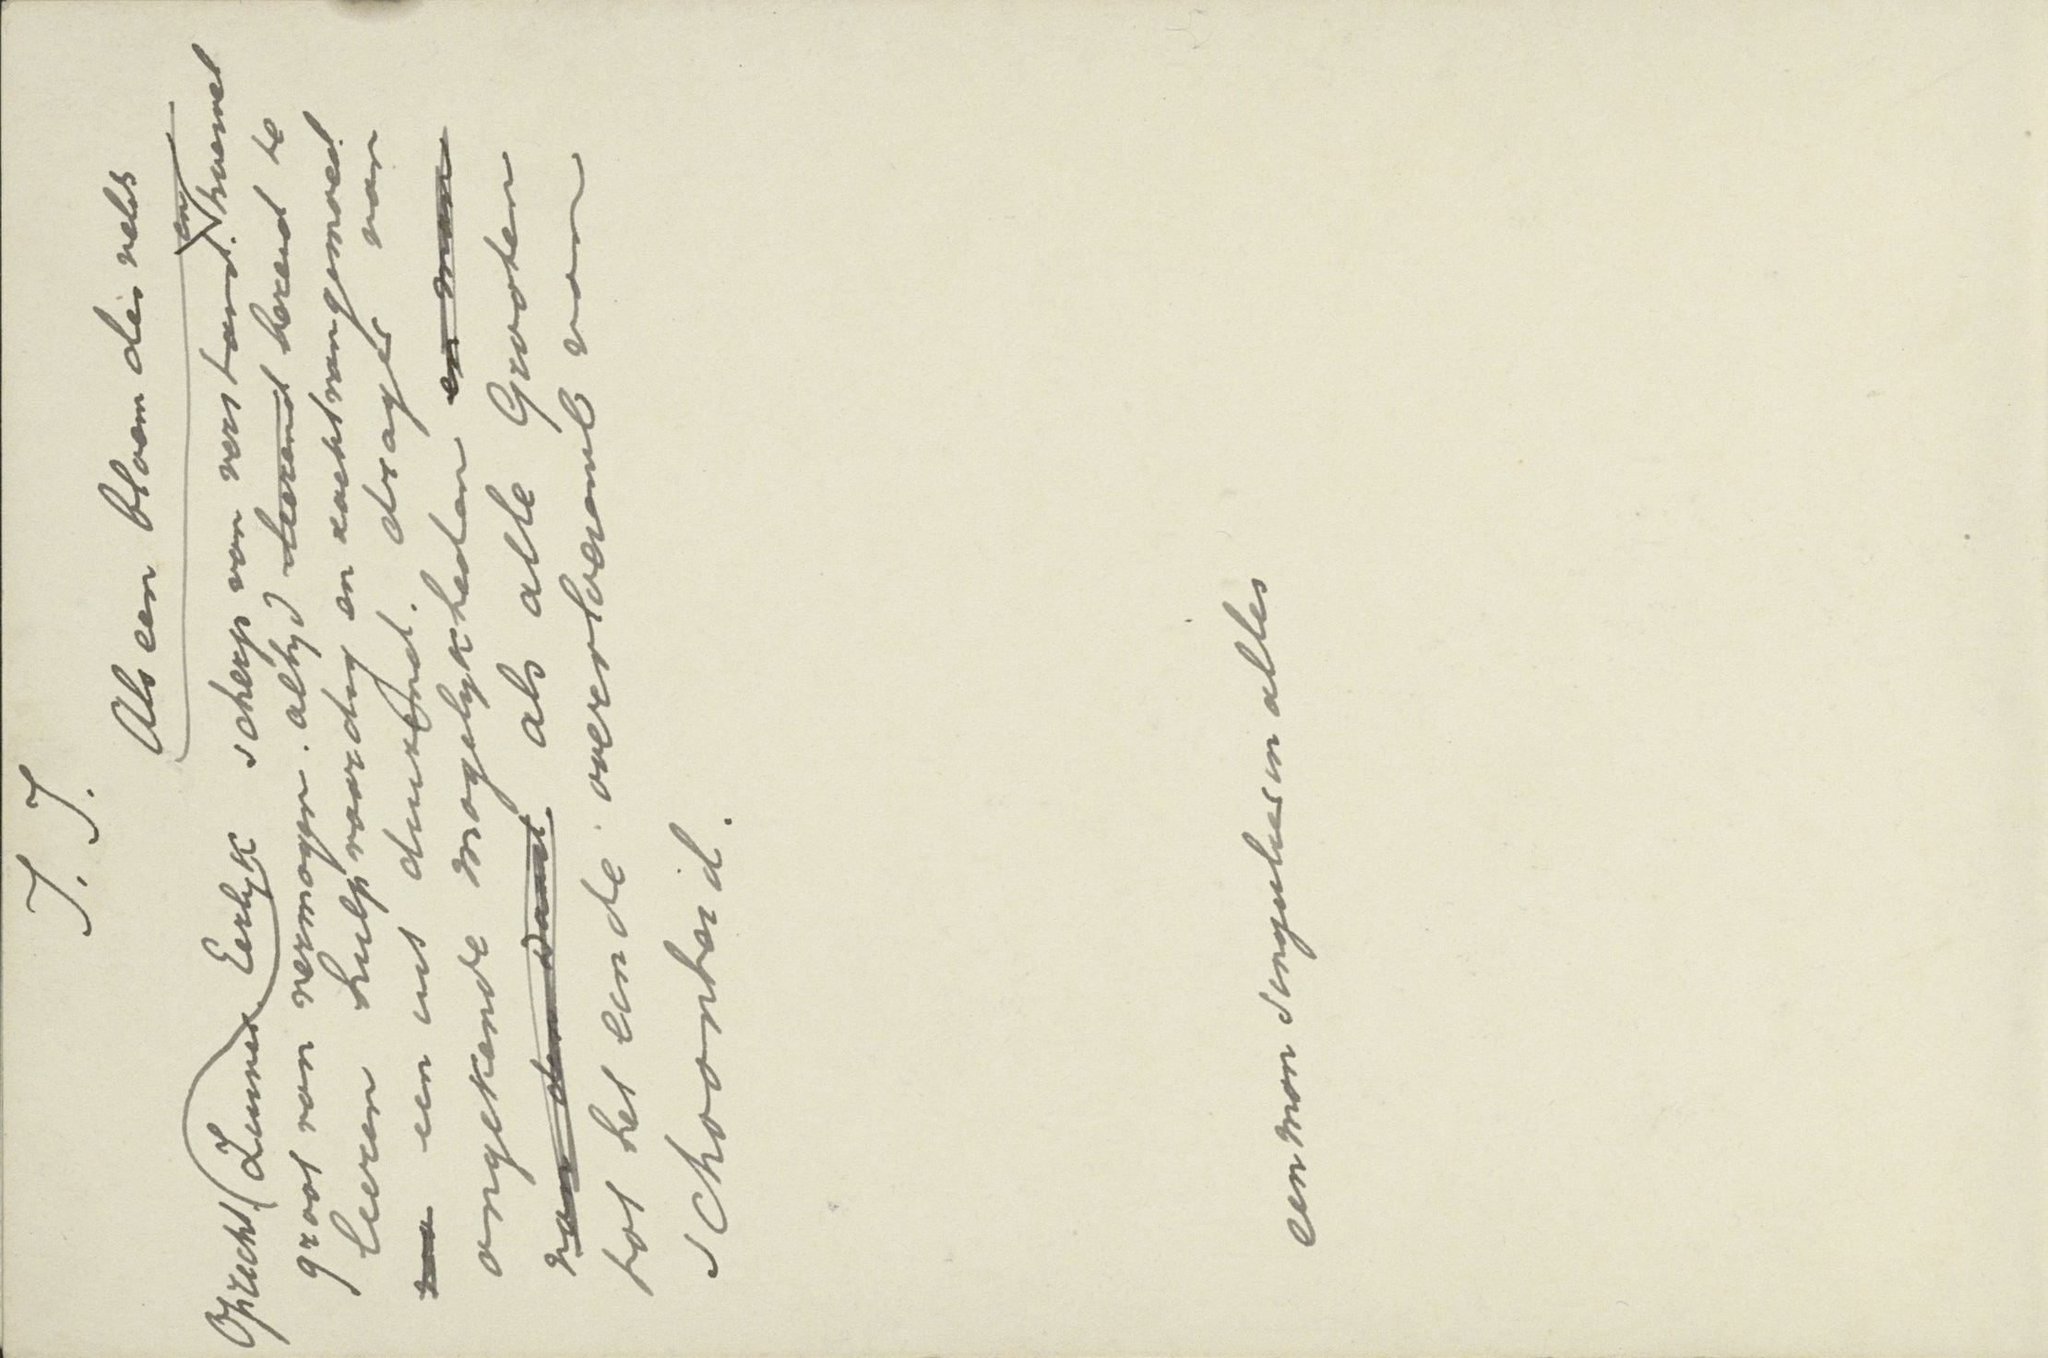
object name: sketchbook leaf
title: Notitie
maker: carel adolph lion cachet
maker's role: draughtsman, print maker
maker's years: 1864-1945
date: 1930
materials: ink, paper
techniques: pen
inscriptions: annotation: ‘J.J./ Als een bloem des ve[...]/ Oprecht. Zuiver. Eerlijk scherp van verstand. en hoewel/ groot van vermogen. altijd horend te leeren hulpvaardig en zacht van gemoed/ een uit duizend. drager van/ ongekende mogelijkheden/ als alle Grooten/ tot het einde overvloeiend van/ schoonheid./ een man singulier in alles’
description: Blad 2 verso uit een schetsboek met 9 bladen.